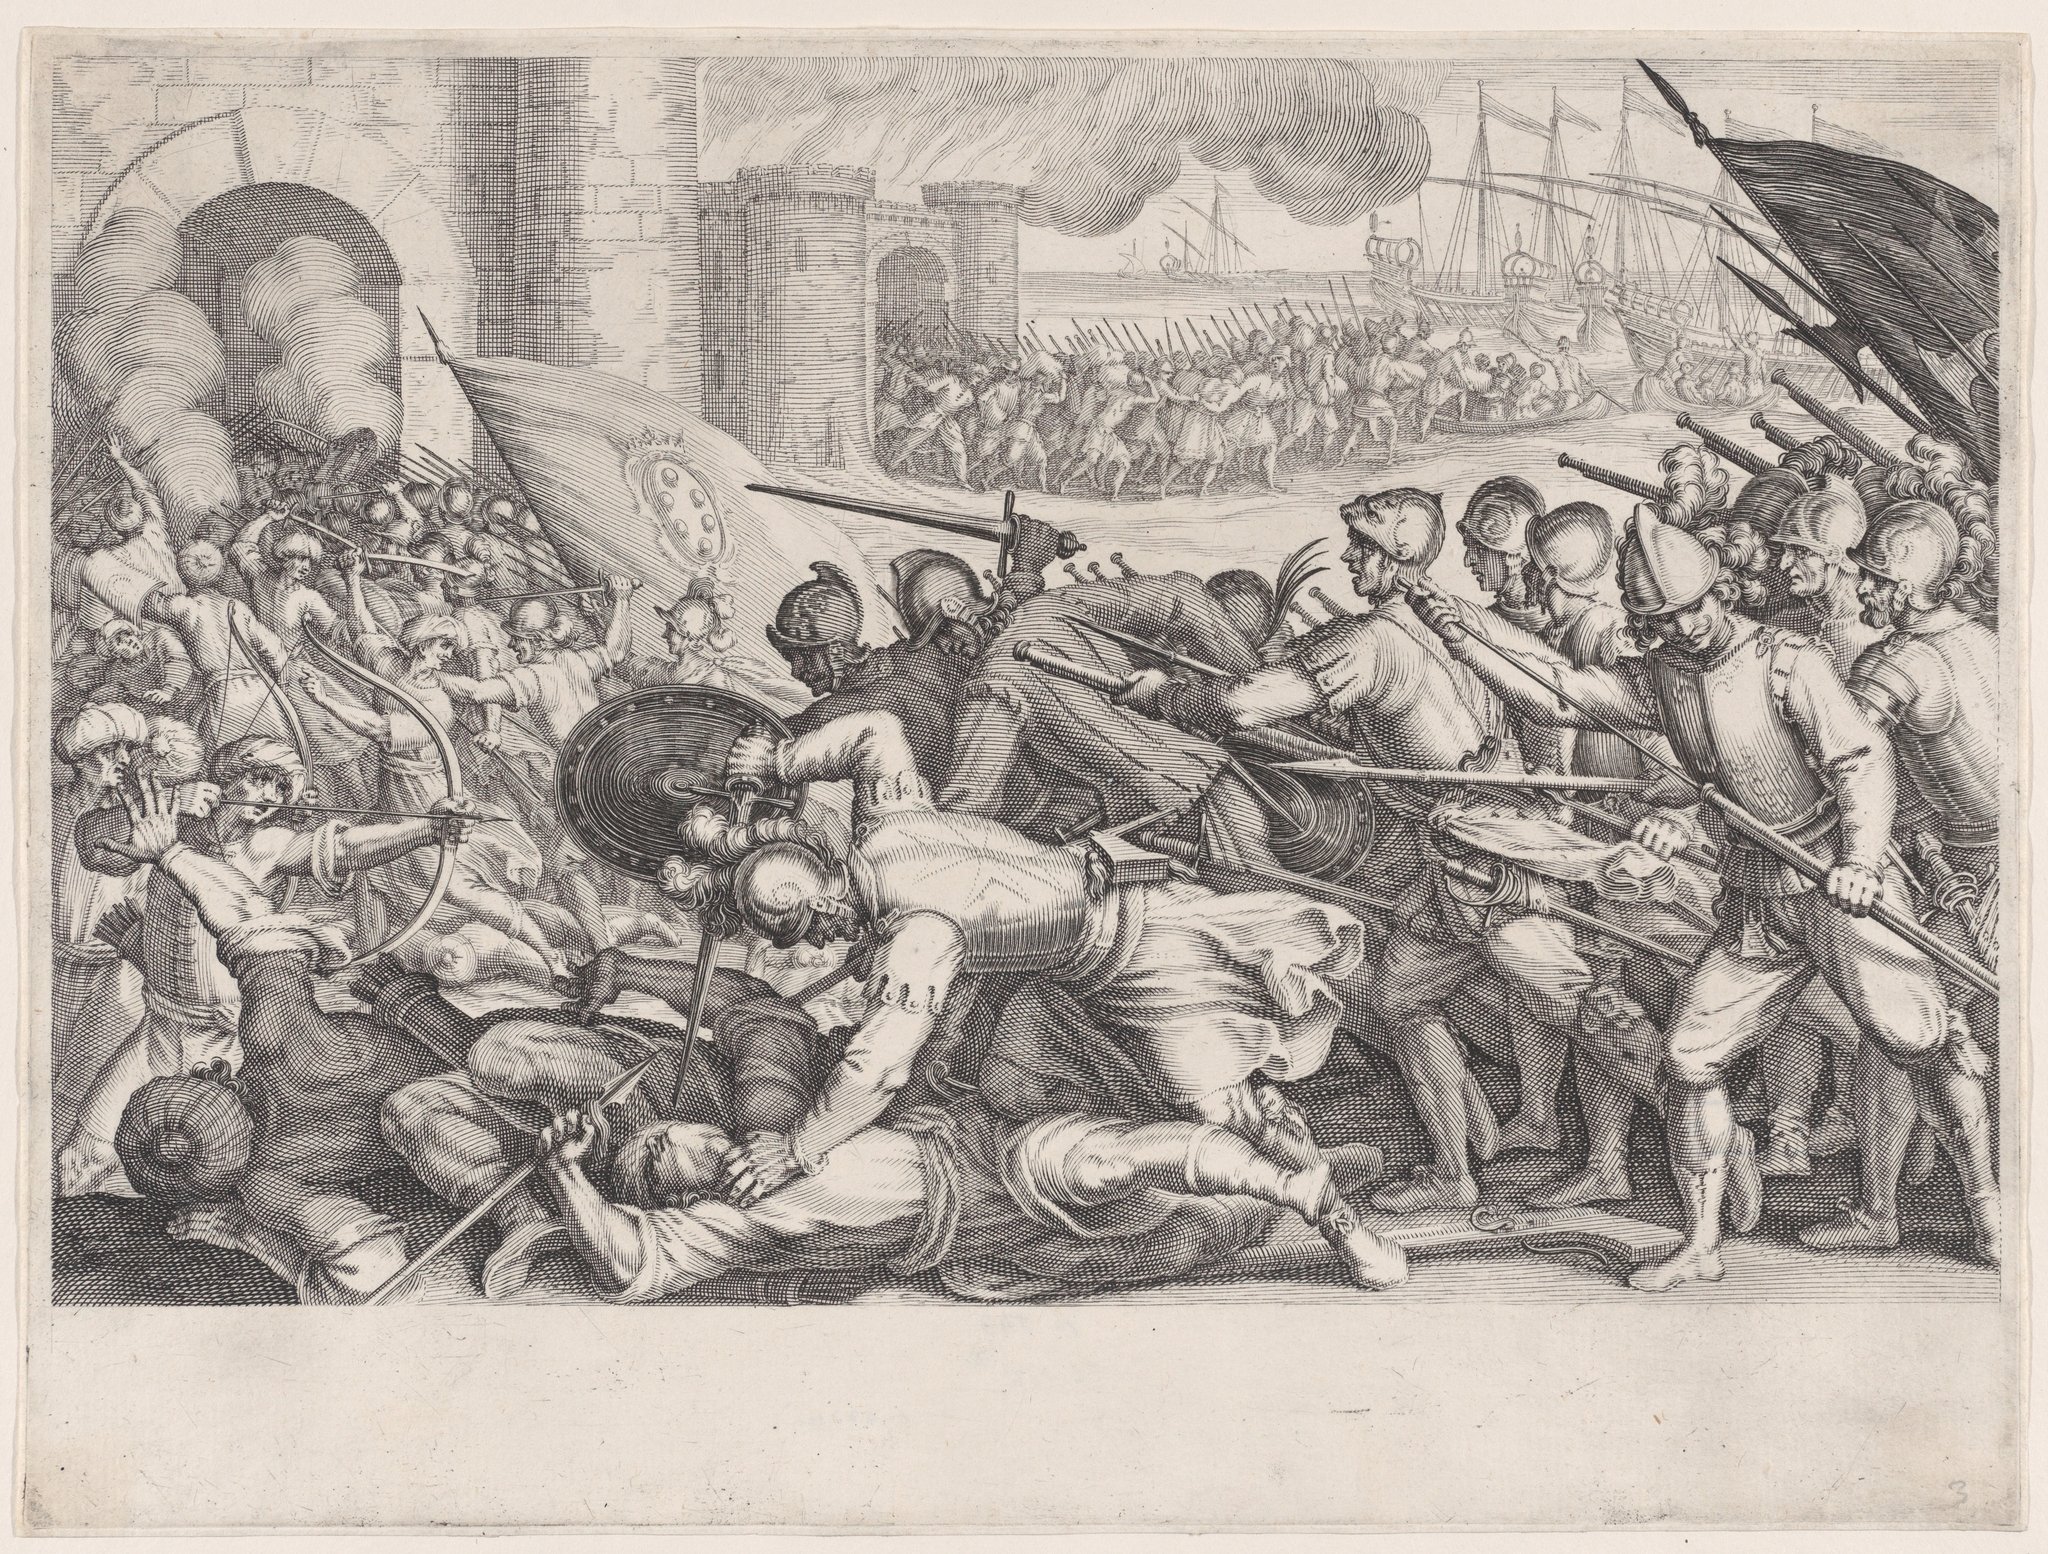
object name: print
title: Les Troupes Forcent la Porte d'une Ville (The Troops Force Their Way Through the Gate of a City), from "La Vie de Ferdinand Ier de Médicis série appelée aussi Les Batailles des Médicis" (The Life of Ferdinand I de'Medici also called The Medici Battles)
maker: jacques callot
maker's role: artist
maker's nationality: french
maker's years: 1592-1635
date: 1614-1620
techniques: engraving